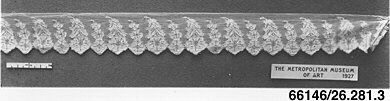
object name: strip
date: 1801-1833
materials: lace, silk